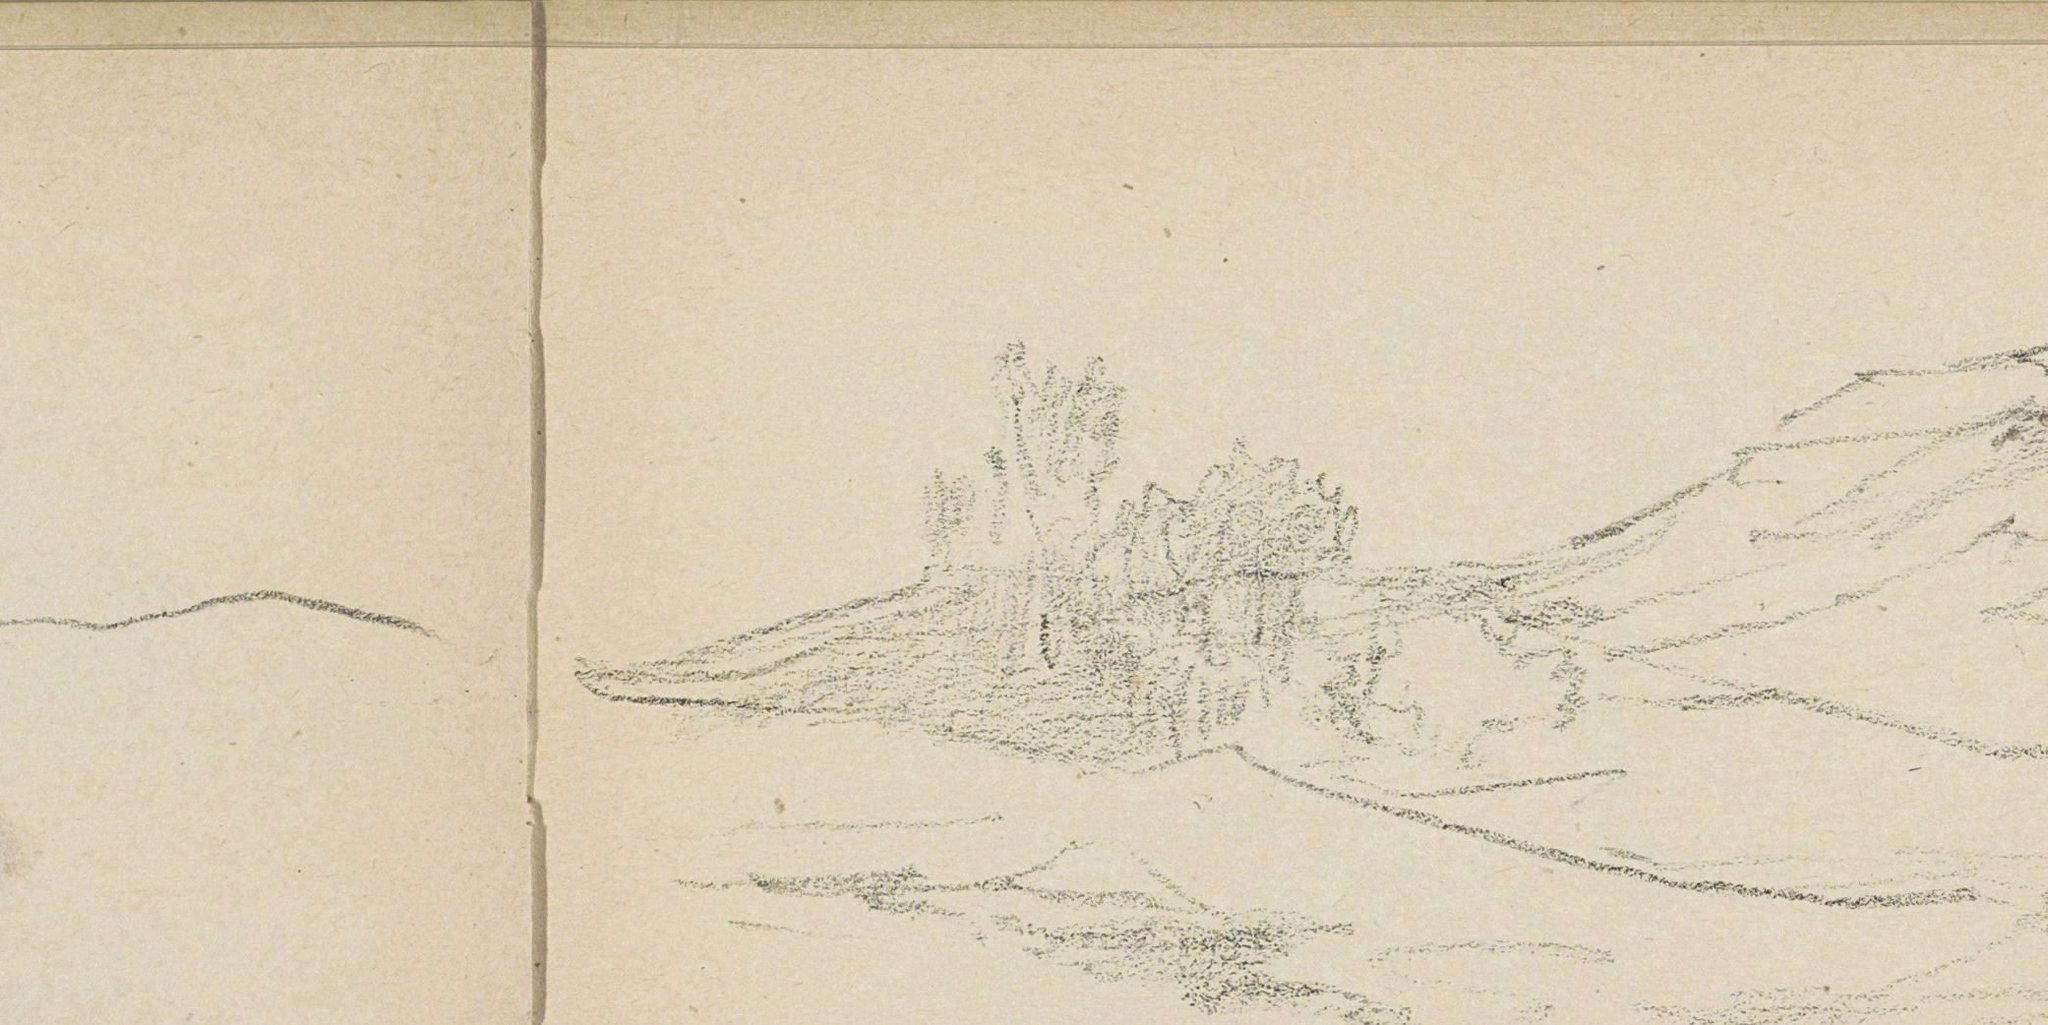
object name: sketchbook leaf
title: Duindal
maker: willem cornelis rip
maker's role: draughtsman, painter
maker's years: 1856-1922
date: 1909-1919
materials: chalk, paper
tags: dale, valley, dune coast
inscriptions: date and inscription: ‘Duindal./ 12 Sept’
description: Blad 6 recto uit een schetsboek met 42 bladen.